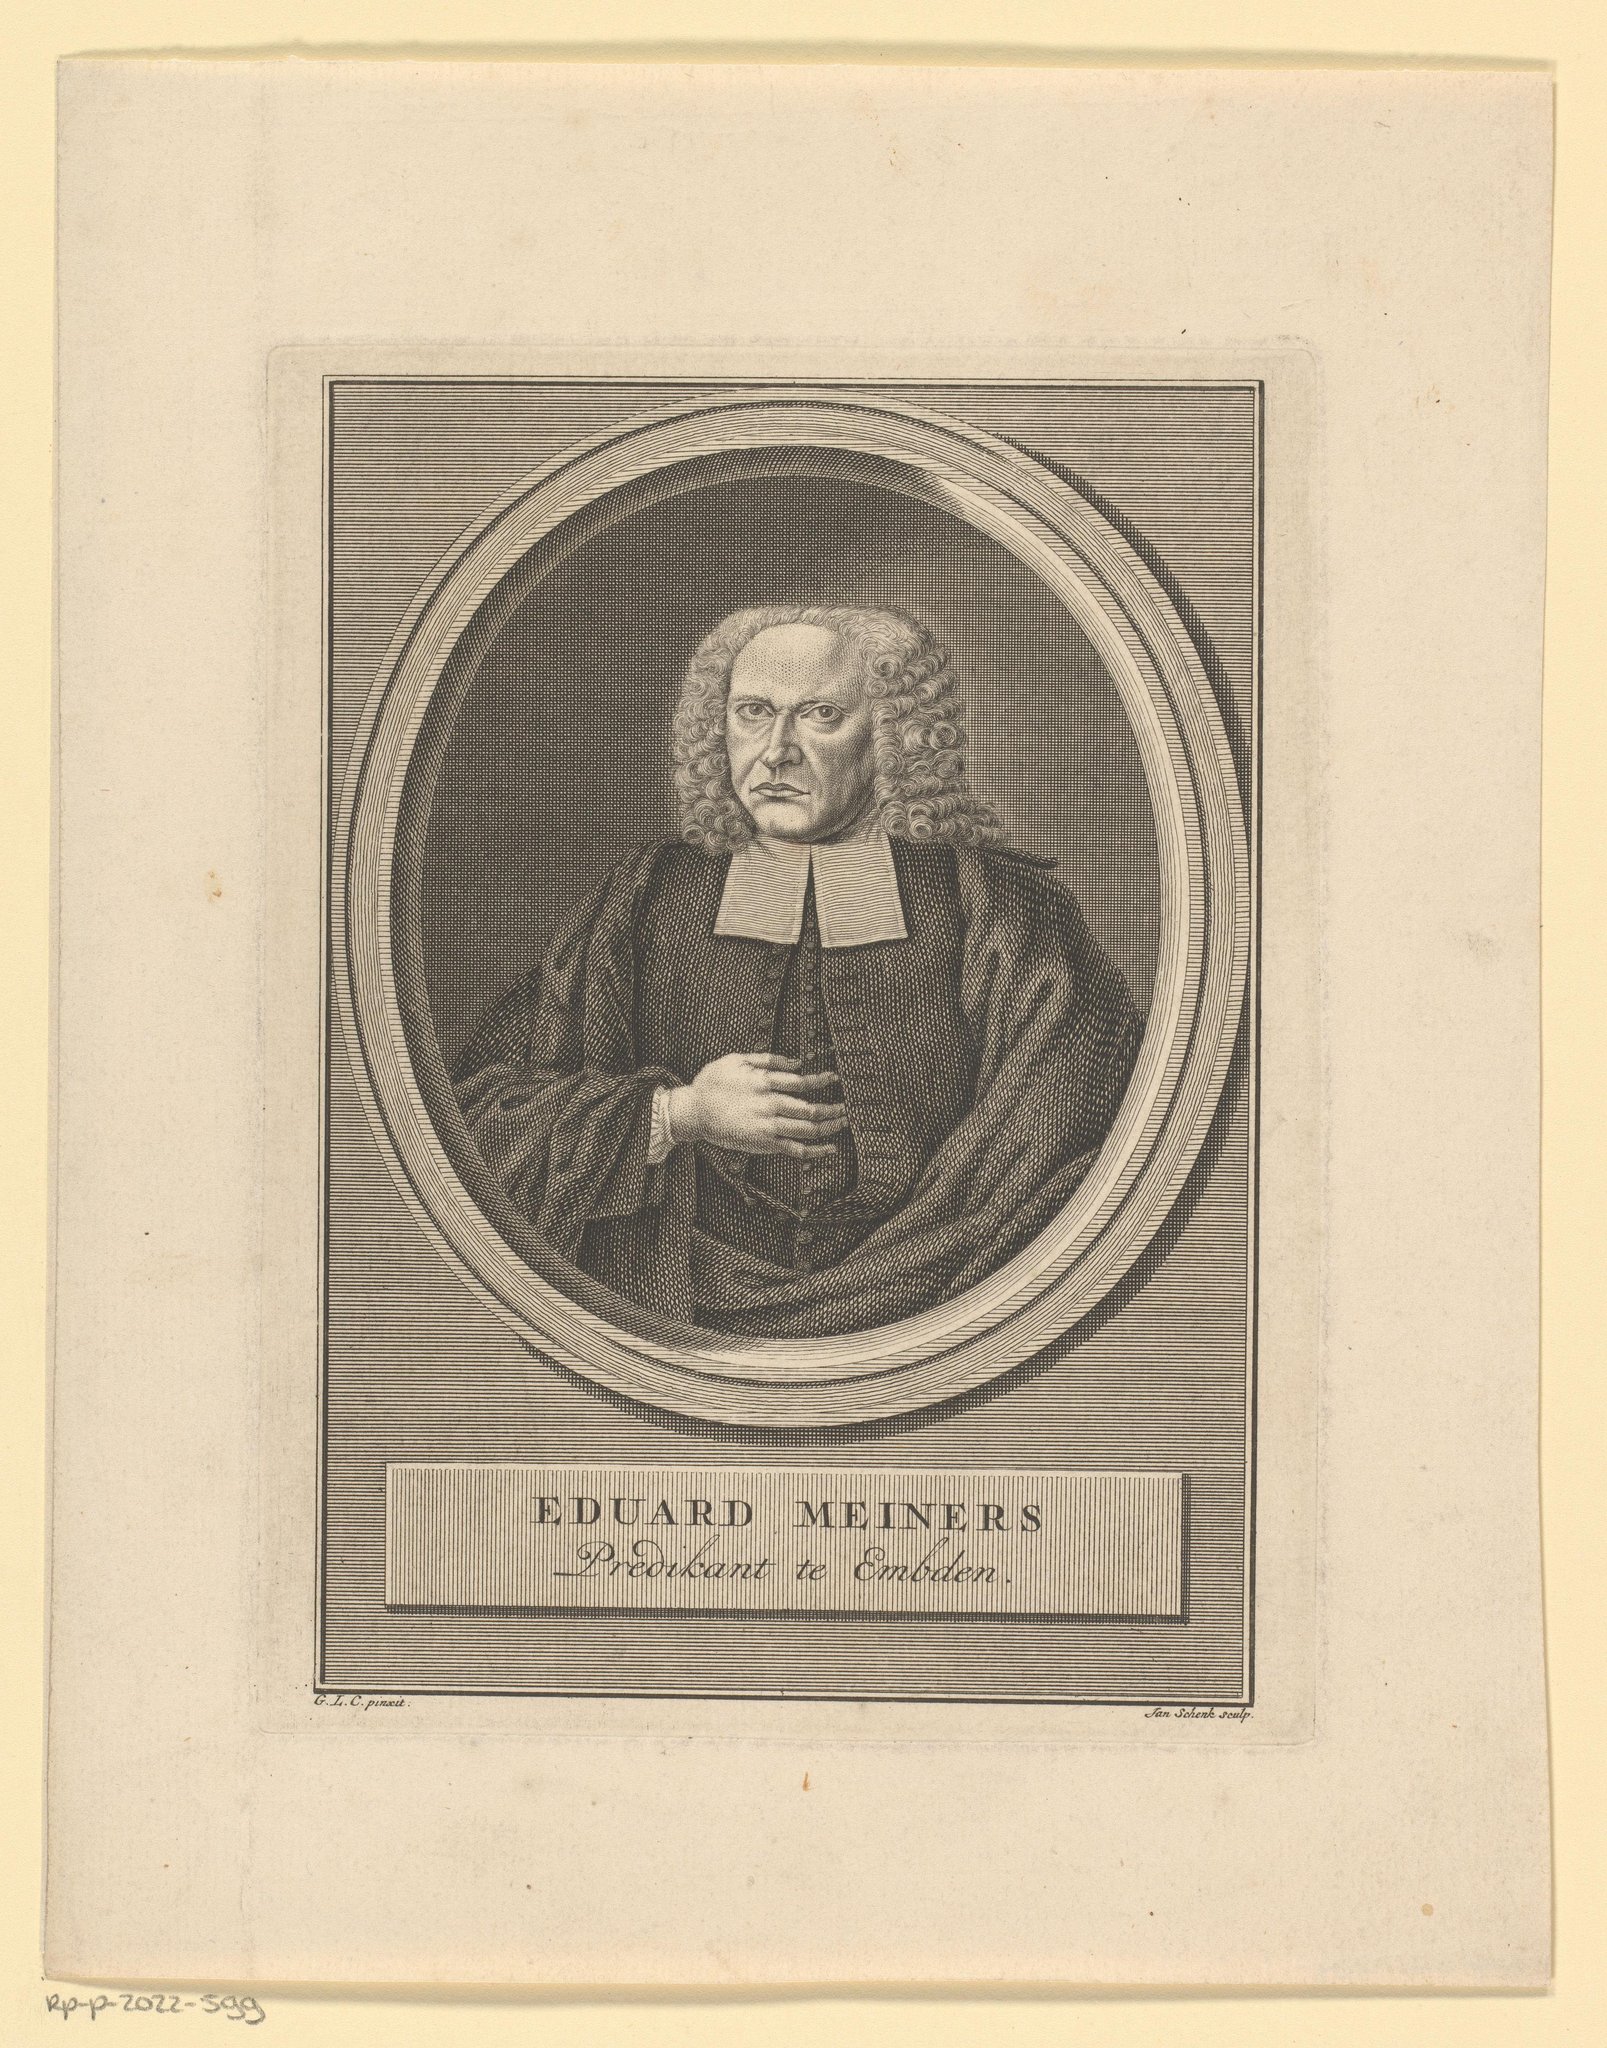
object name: print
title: Portret van Eduard Meiners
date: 1738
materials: paper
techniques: engraving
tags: historical persons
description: Prent waarschijnlijk uit: Meiners, Eduard. Kerklyke Geschiedenisse van Oostvriesland. S.l.s.n., 1738.